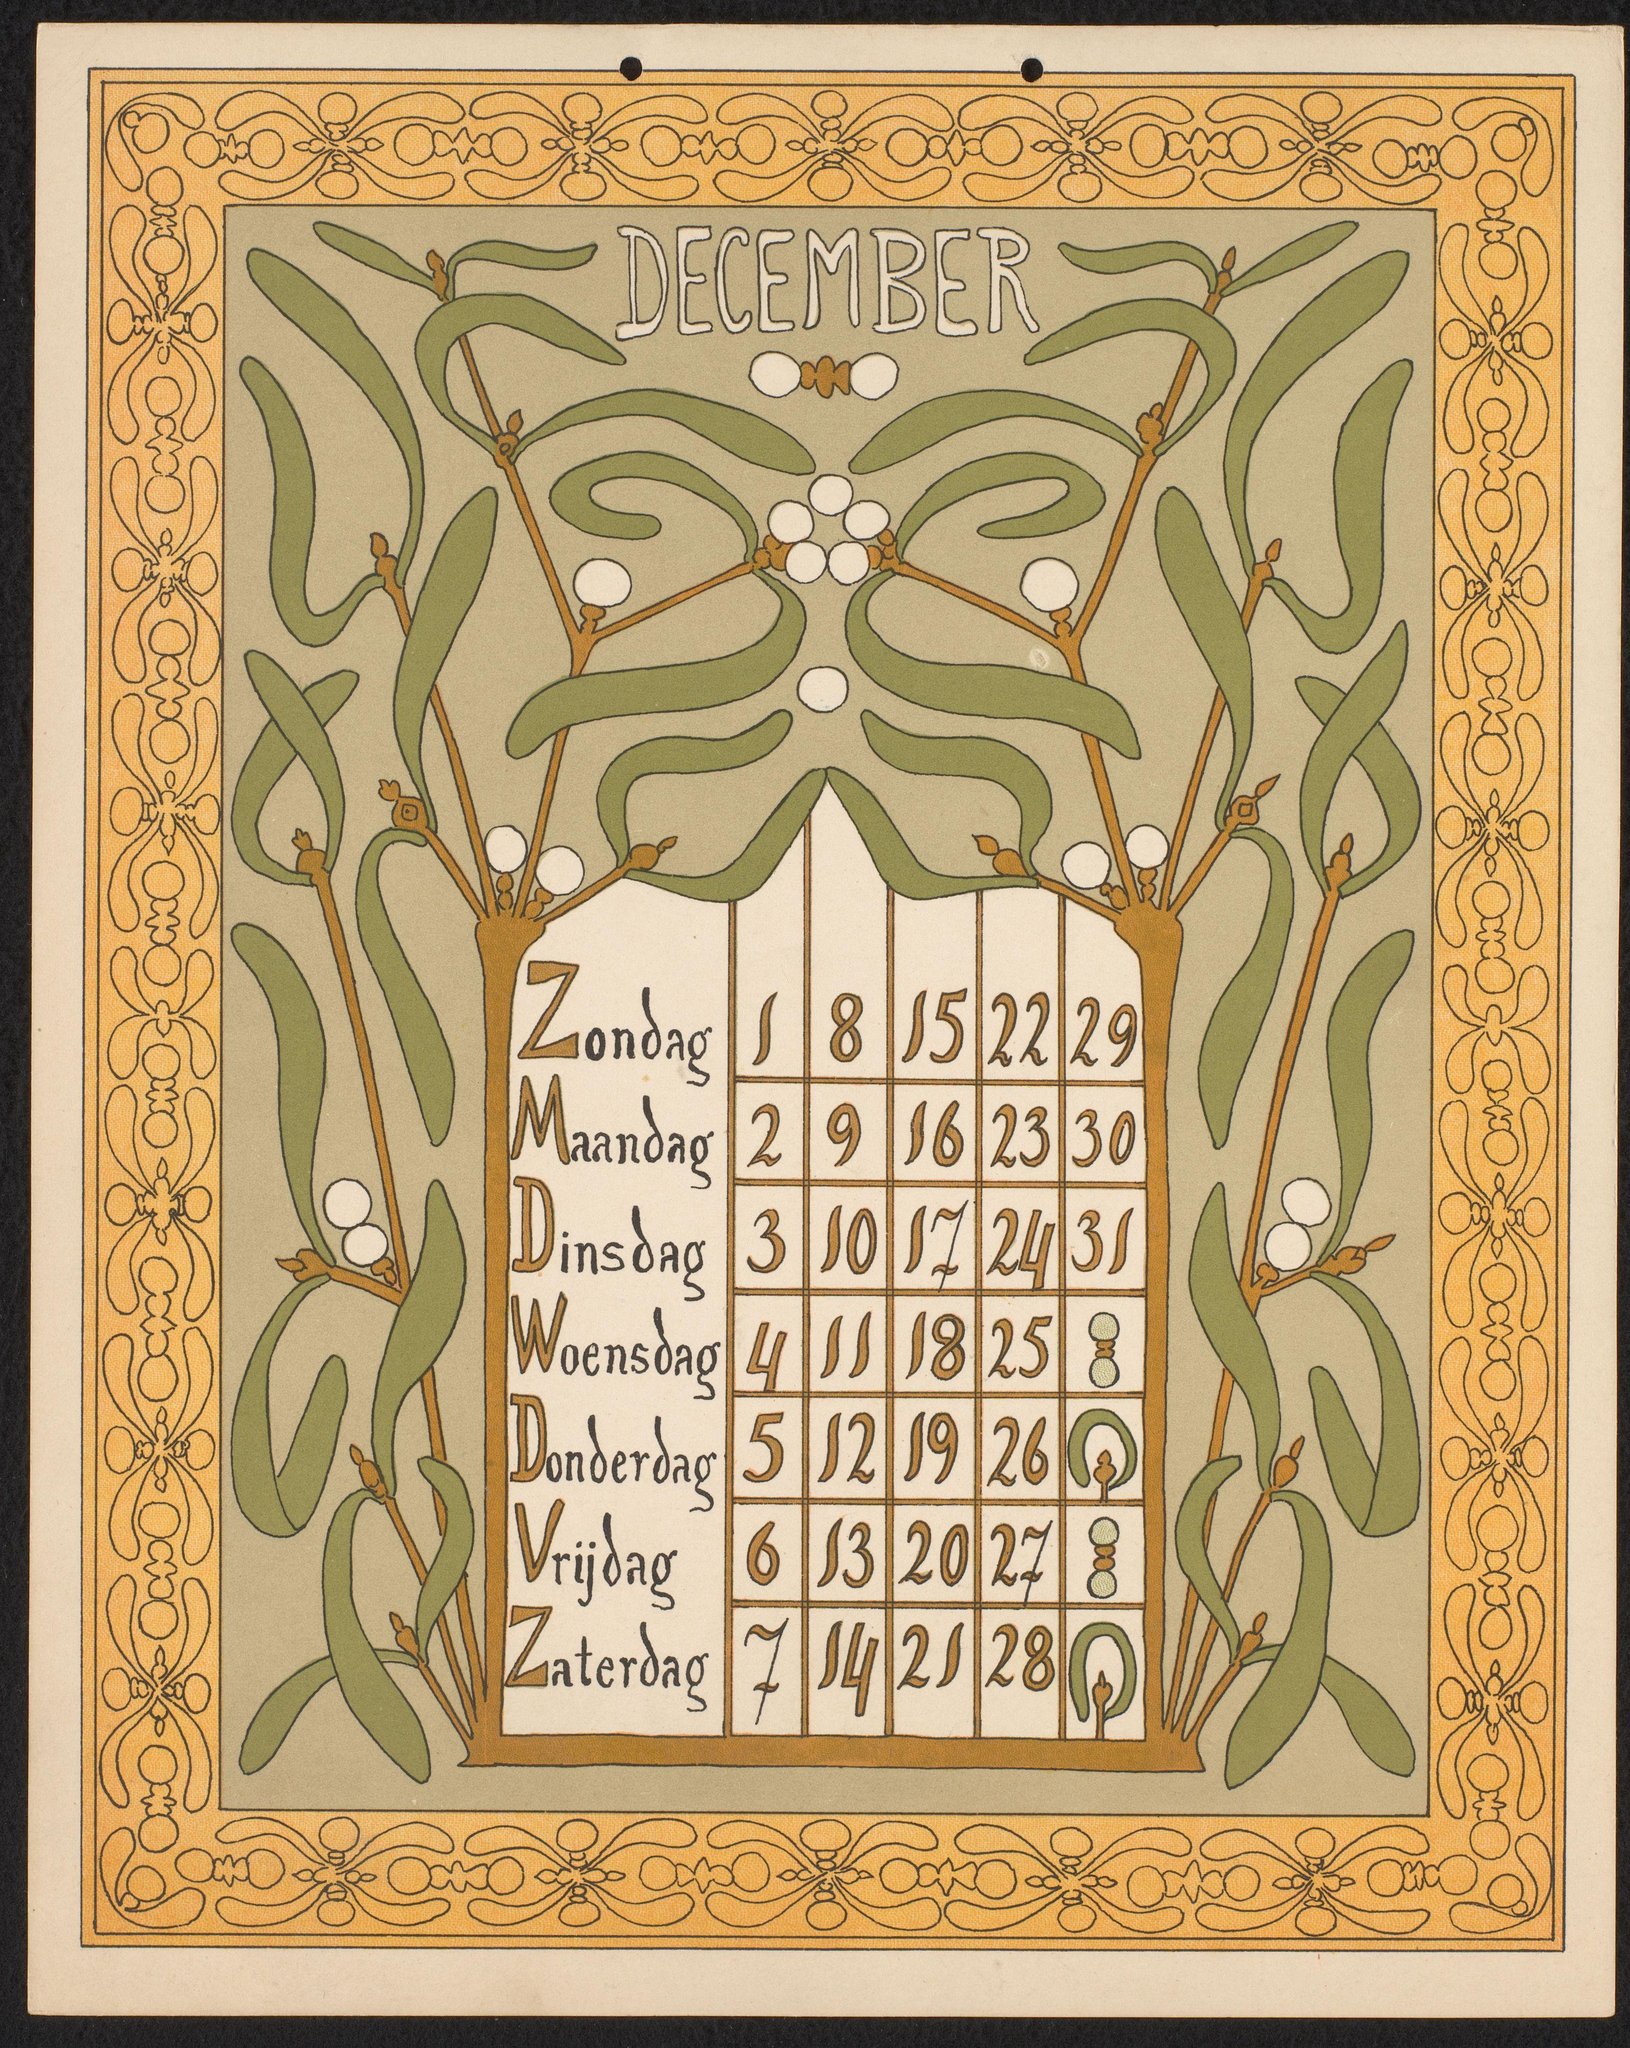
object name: calendar leaf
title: Kalenderblad voor december 1901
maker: c.a.j. van dishoeck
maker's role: publisher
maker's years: 1863-1931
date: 1900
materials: paper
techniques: lithograph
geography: amsterdam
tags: ornaments ~ art, calendar, almanac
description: Kalenderblad voor december 1901 van de kalender 'Bloem en Blad', met een randdecoratie van een plant met witte bessen.